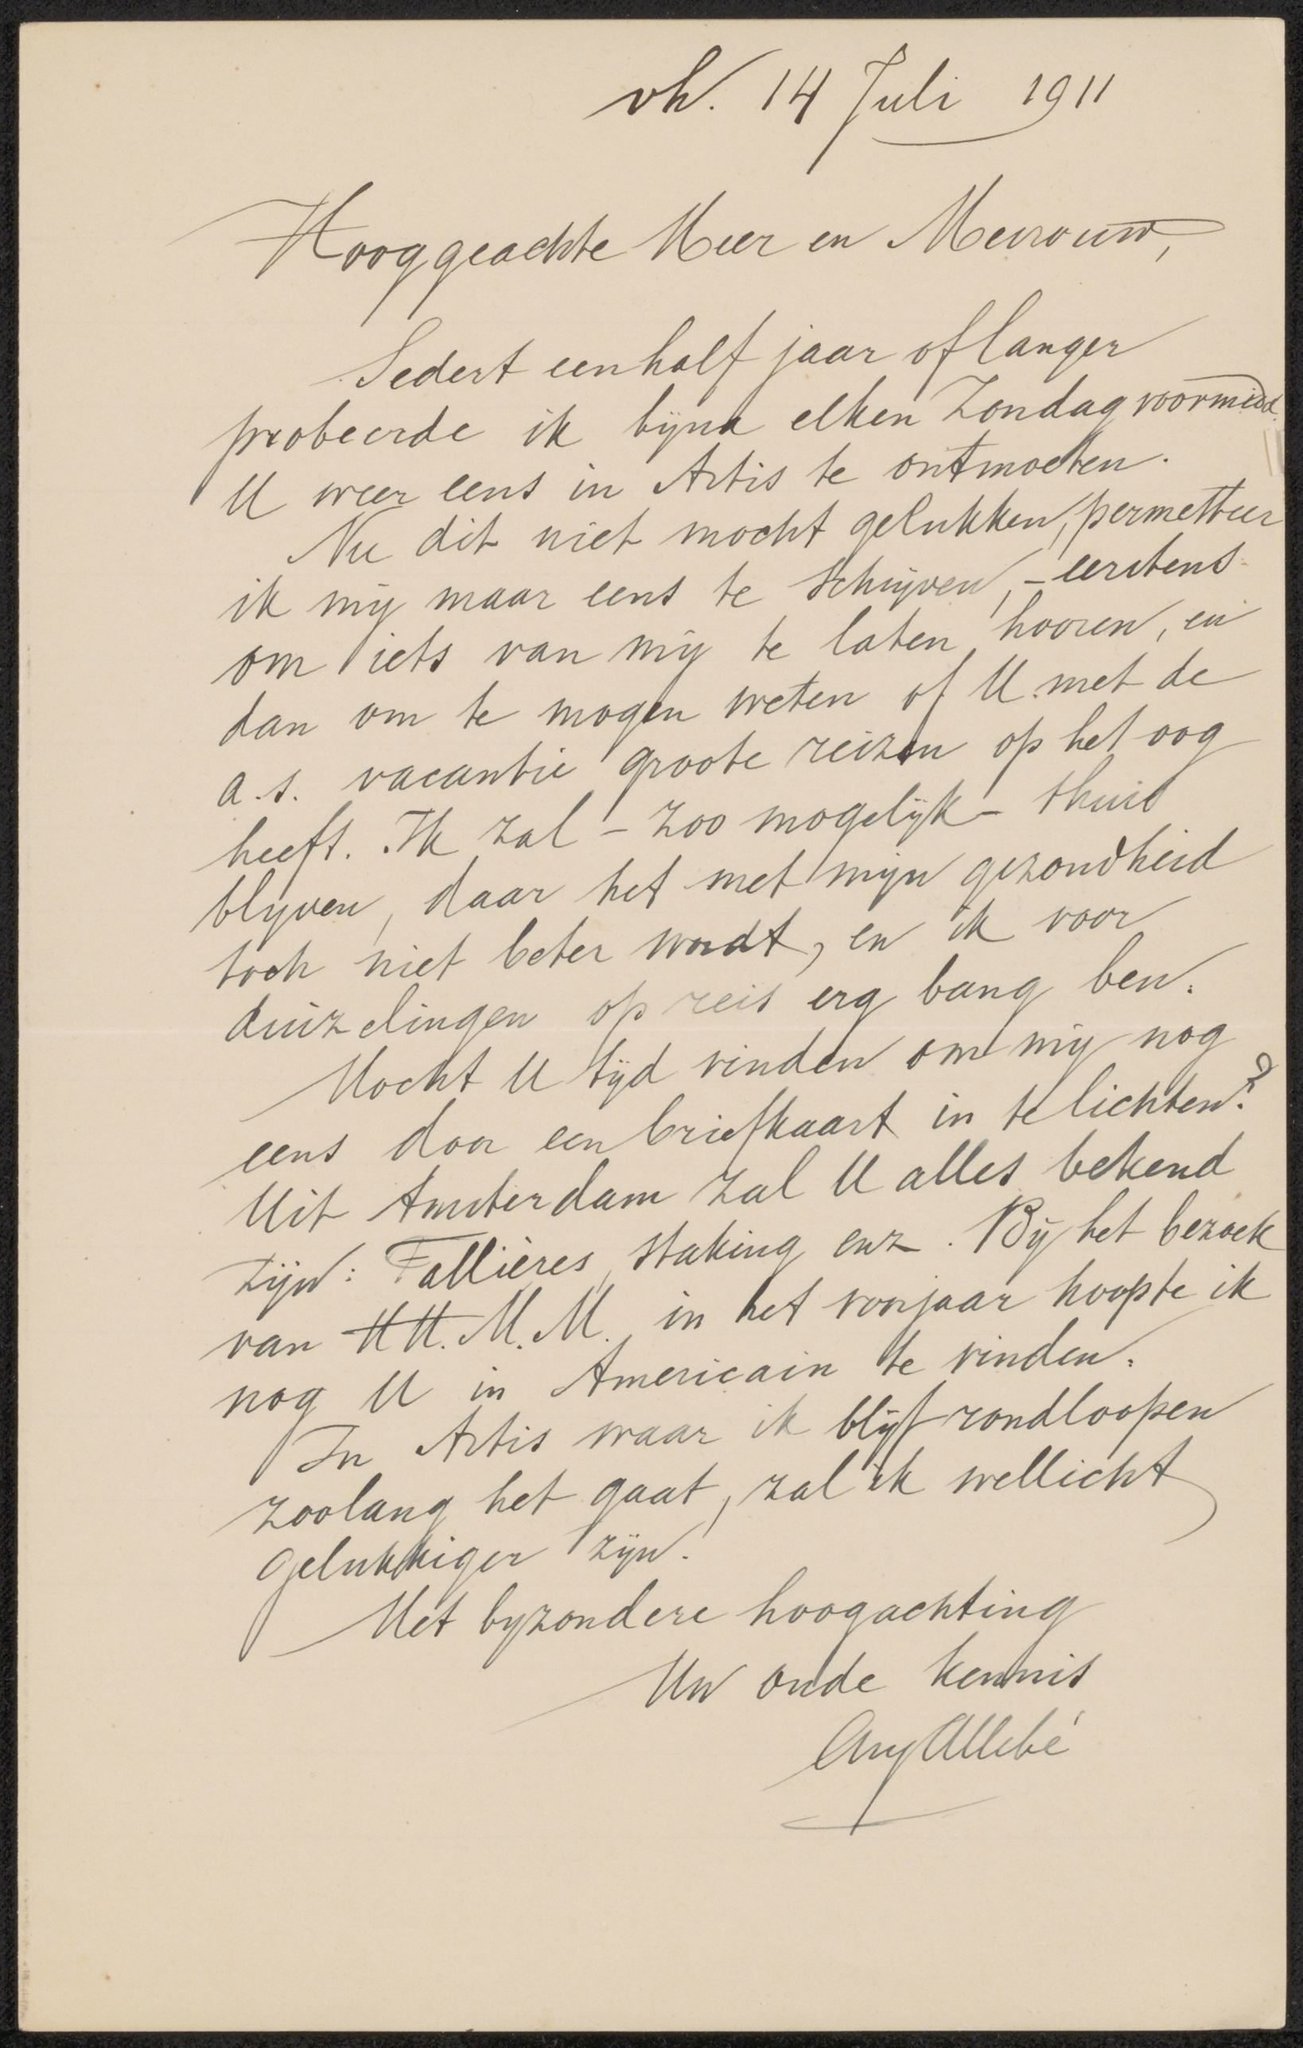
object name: letter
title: Brief aan Max Wilhelm Carl Weber en Anne Antoinette Weber-Van Bosse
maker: august allebé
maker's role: draughtsman, print maker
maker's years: 1838-1927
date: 1911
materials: ink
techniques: pen, writing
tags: amsterdam, anne antoinette weber-van bosse